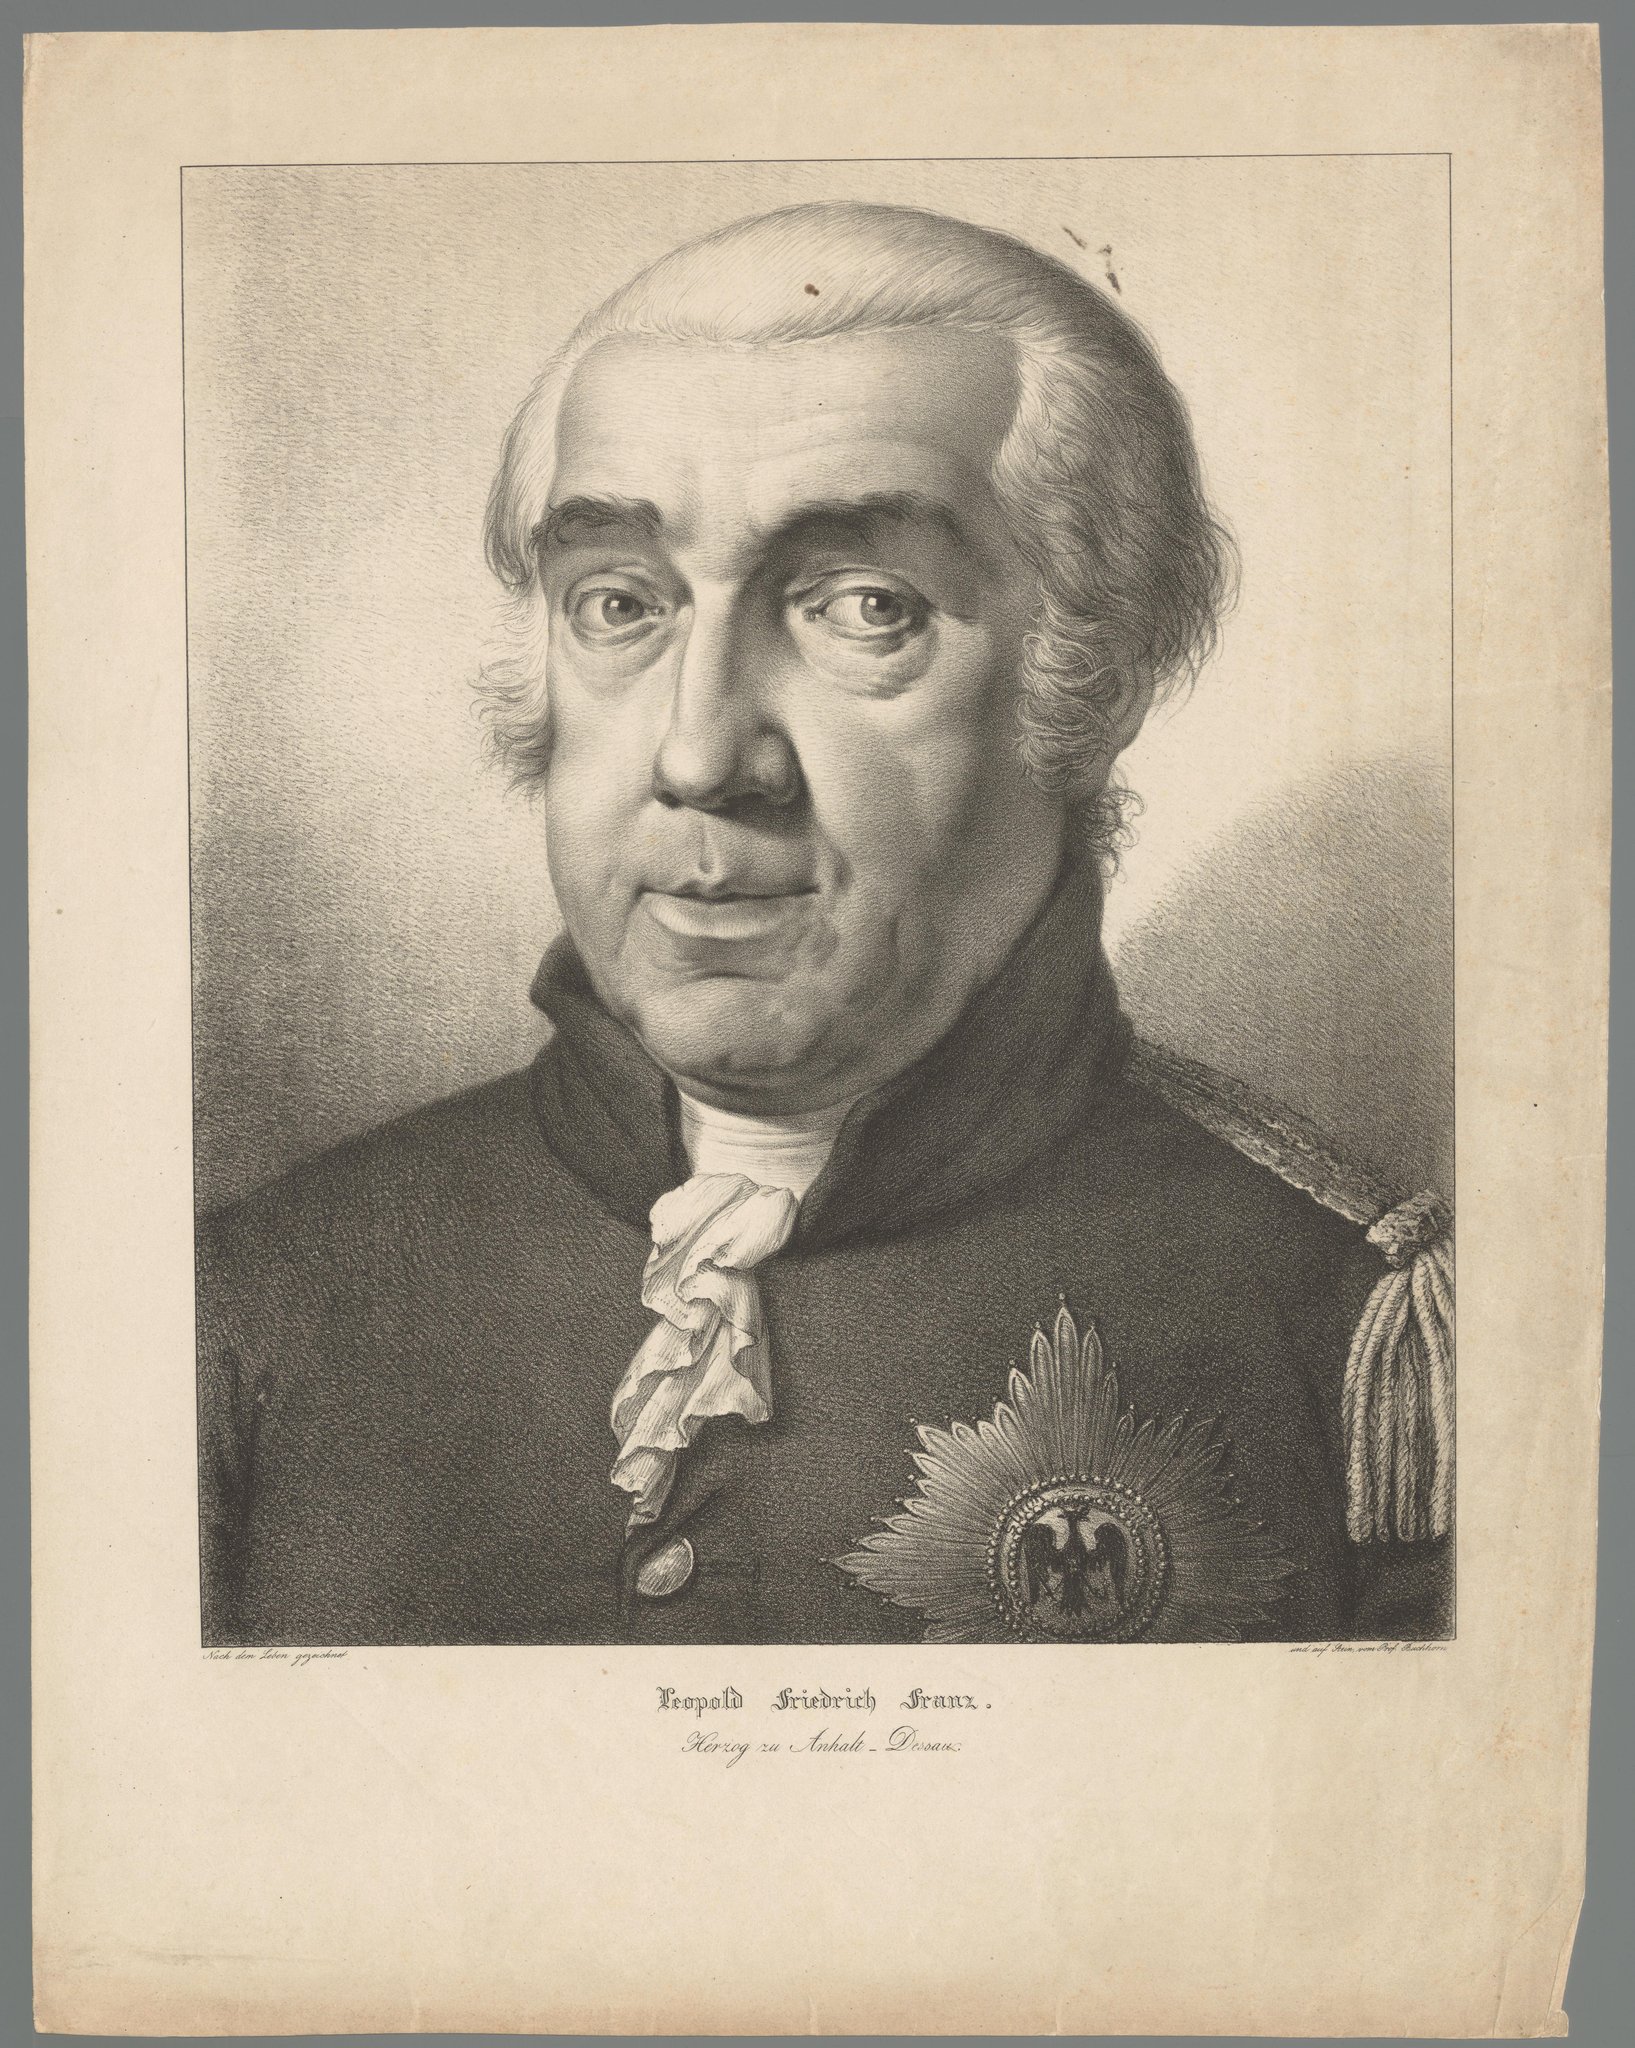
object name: print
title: Leopold Friedrich Franz, Herzog zu Anhalt-Dessau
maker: ludwig buchhorn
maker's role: painter, print maker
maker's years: 1770-1856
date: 1820-1856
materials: paper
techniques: lithograph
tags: leopold iii frederik frans van anhalt-dessau, adult man, historical persons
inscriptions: collector's mark: Lugt 2228